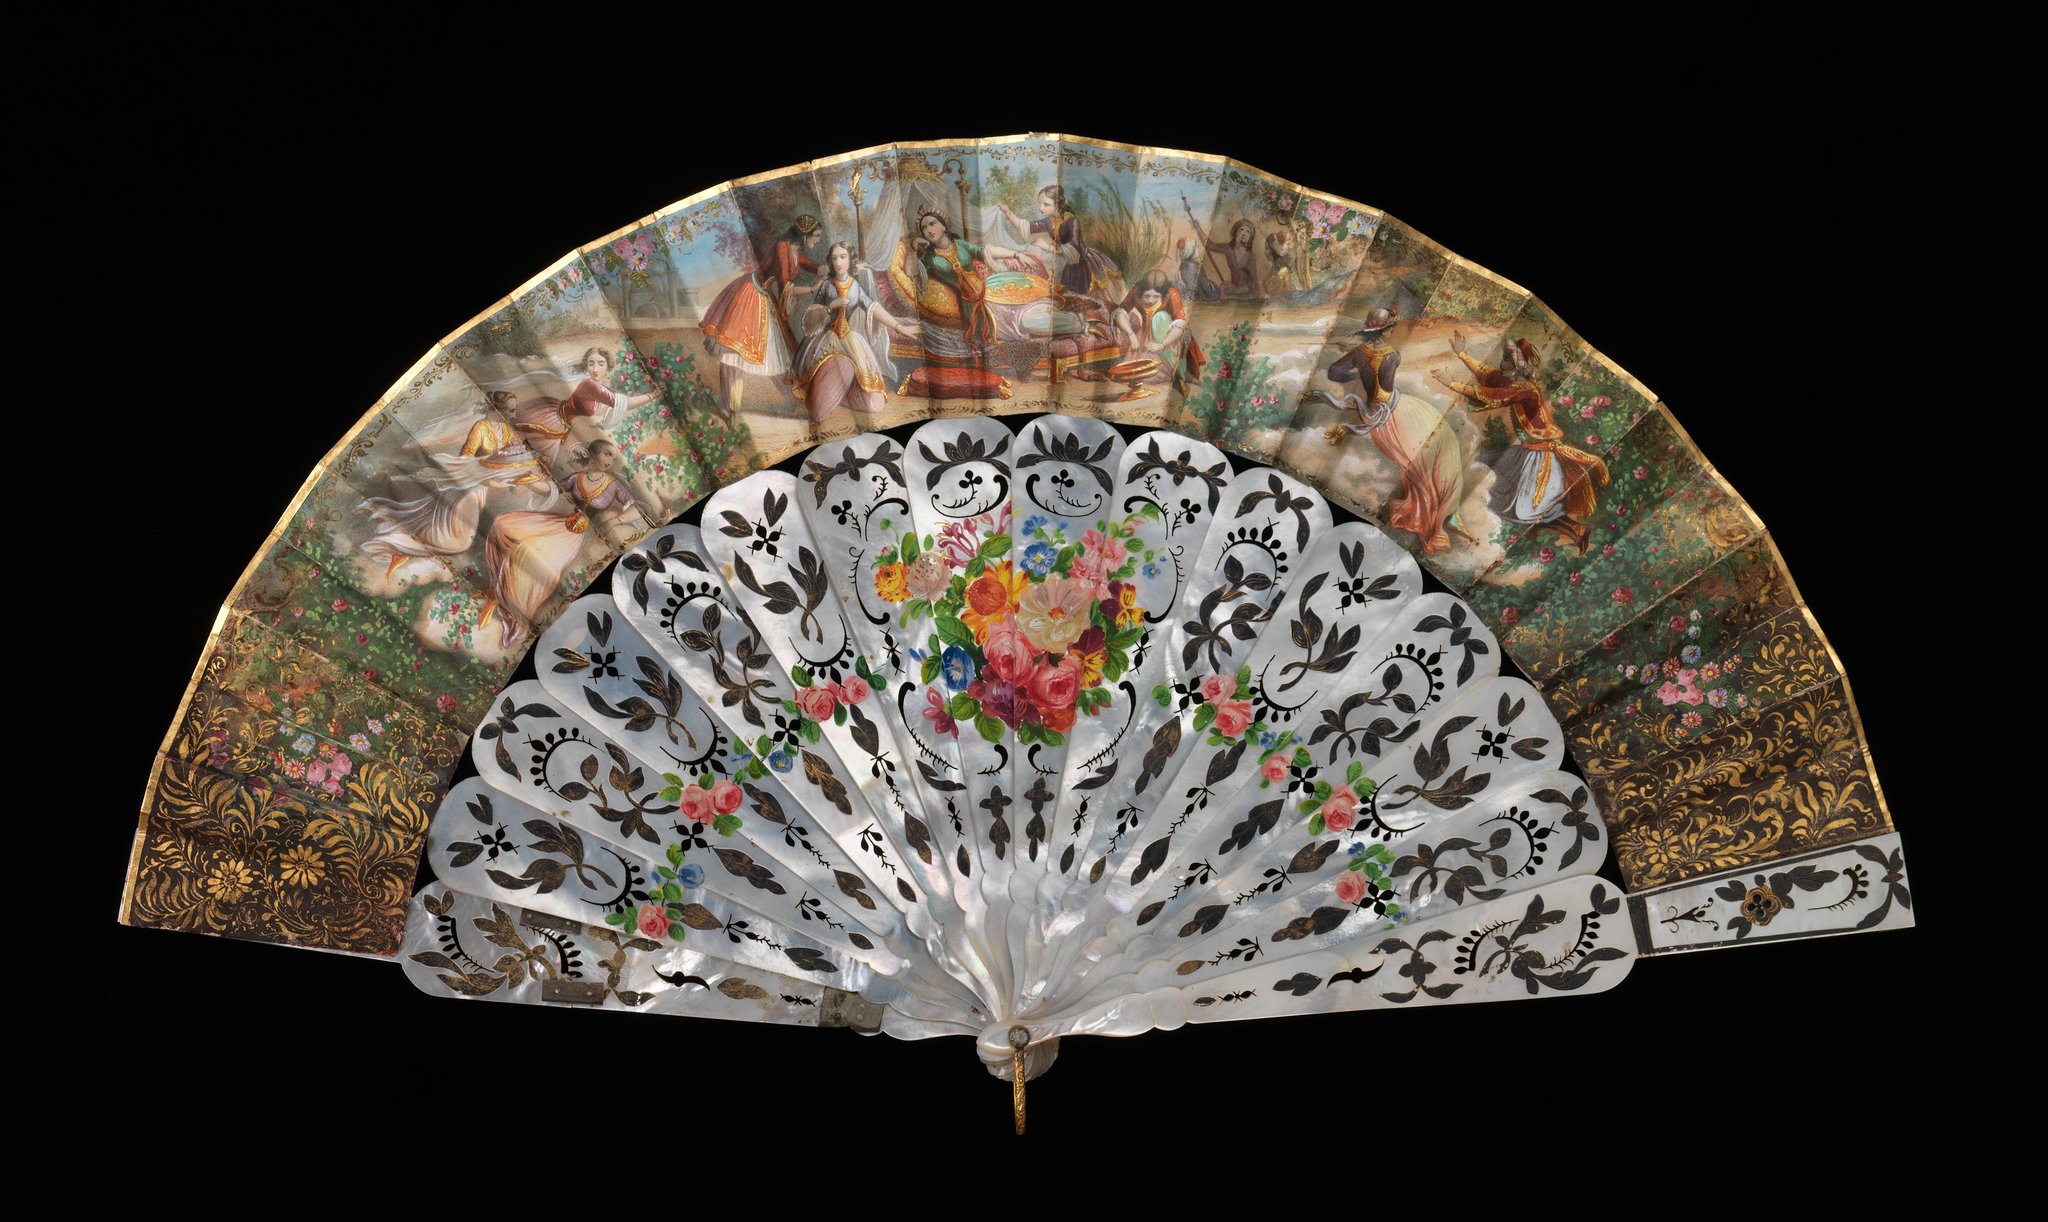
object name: fan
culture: european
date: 1855-1865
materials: gouache, metal, mother of pearl, paper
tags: girls,women